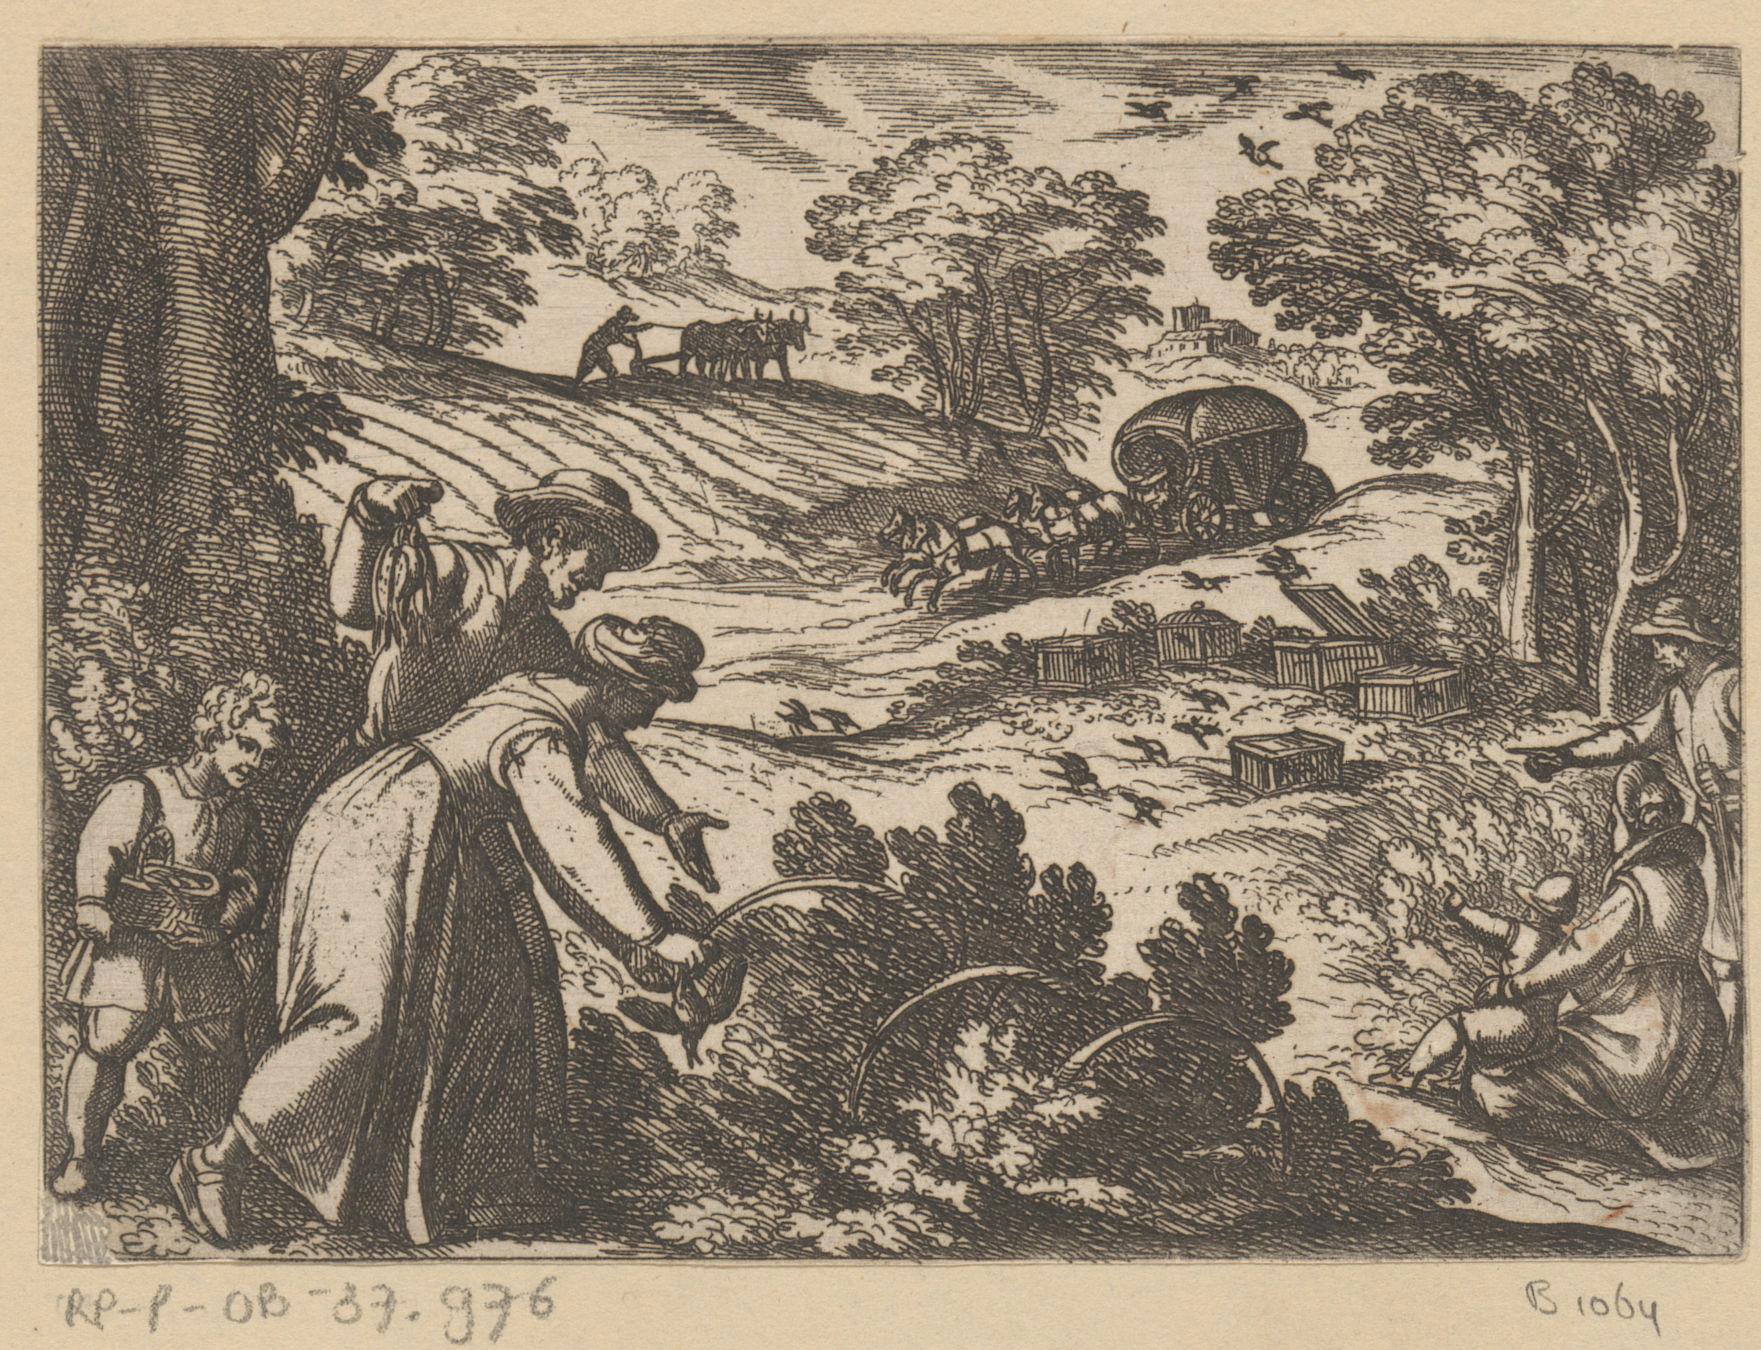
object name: print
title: Primo libro di caccie varie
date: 1598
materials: paper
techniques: etching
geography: italy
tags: hunter, hunters hunting (n.b.: in 1988-1990 this notation denoted the concept of 43c11421 'hunters resting during the hunt'), bird hunting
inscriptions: collector's mark: Lugt 240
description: Een landschap met op de voorgrond twee gezinnen die met behulp van verschillende vallen en strikken vogels vangen. Op de achtergrond een boer die het veld ploegt met zijn ossen.